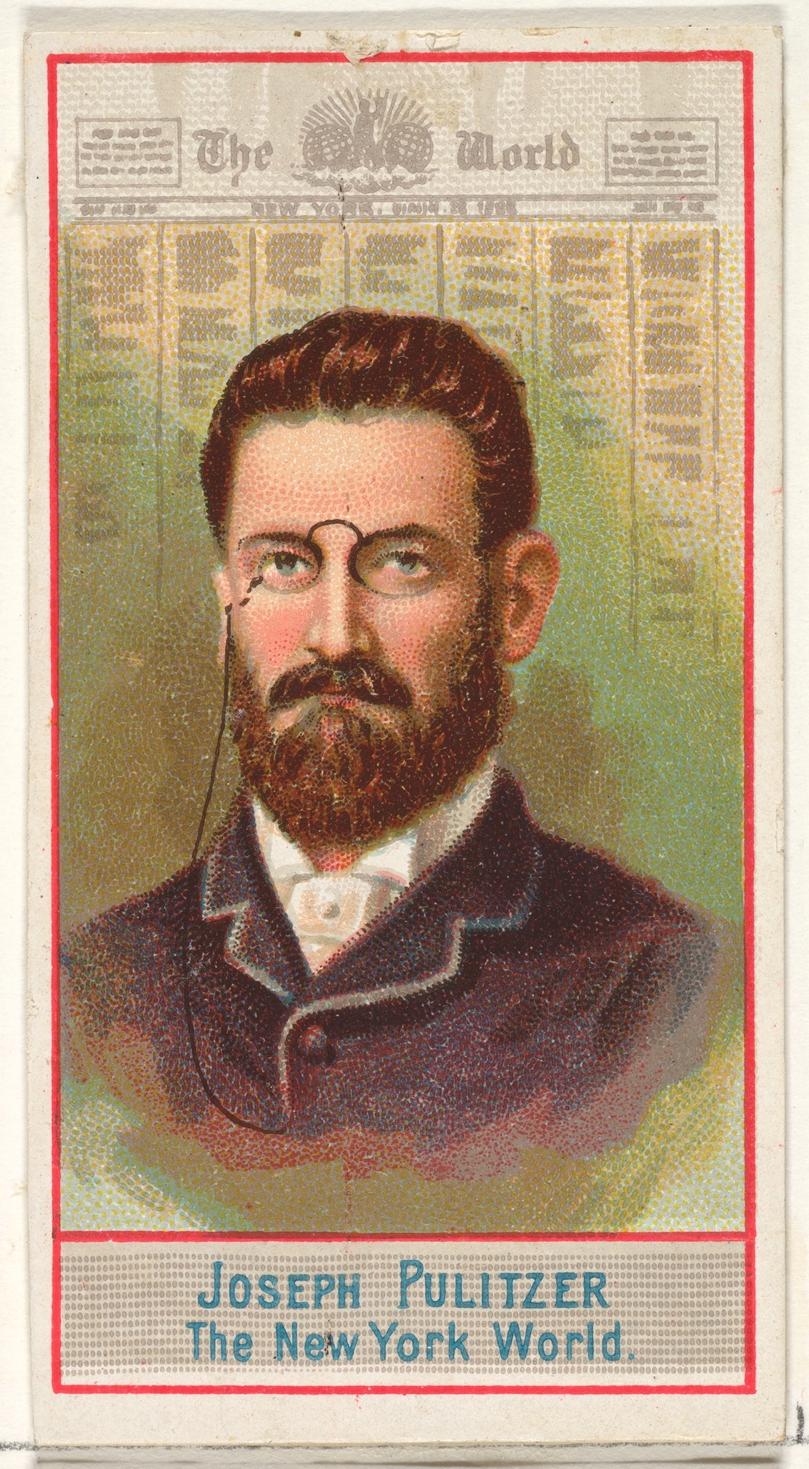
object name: print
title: Joseph Pulitzer, The New York World, from the American Editors series (N1) for Allen & Ginter Cigarettes Brands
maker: allen & ginter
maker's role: publisher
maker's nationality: american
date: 1887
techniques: color lithograph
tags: men,portraits